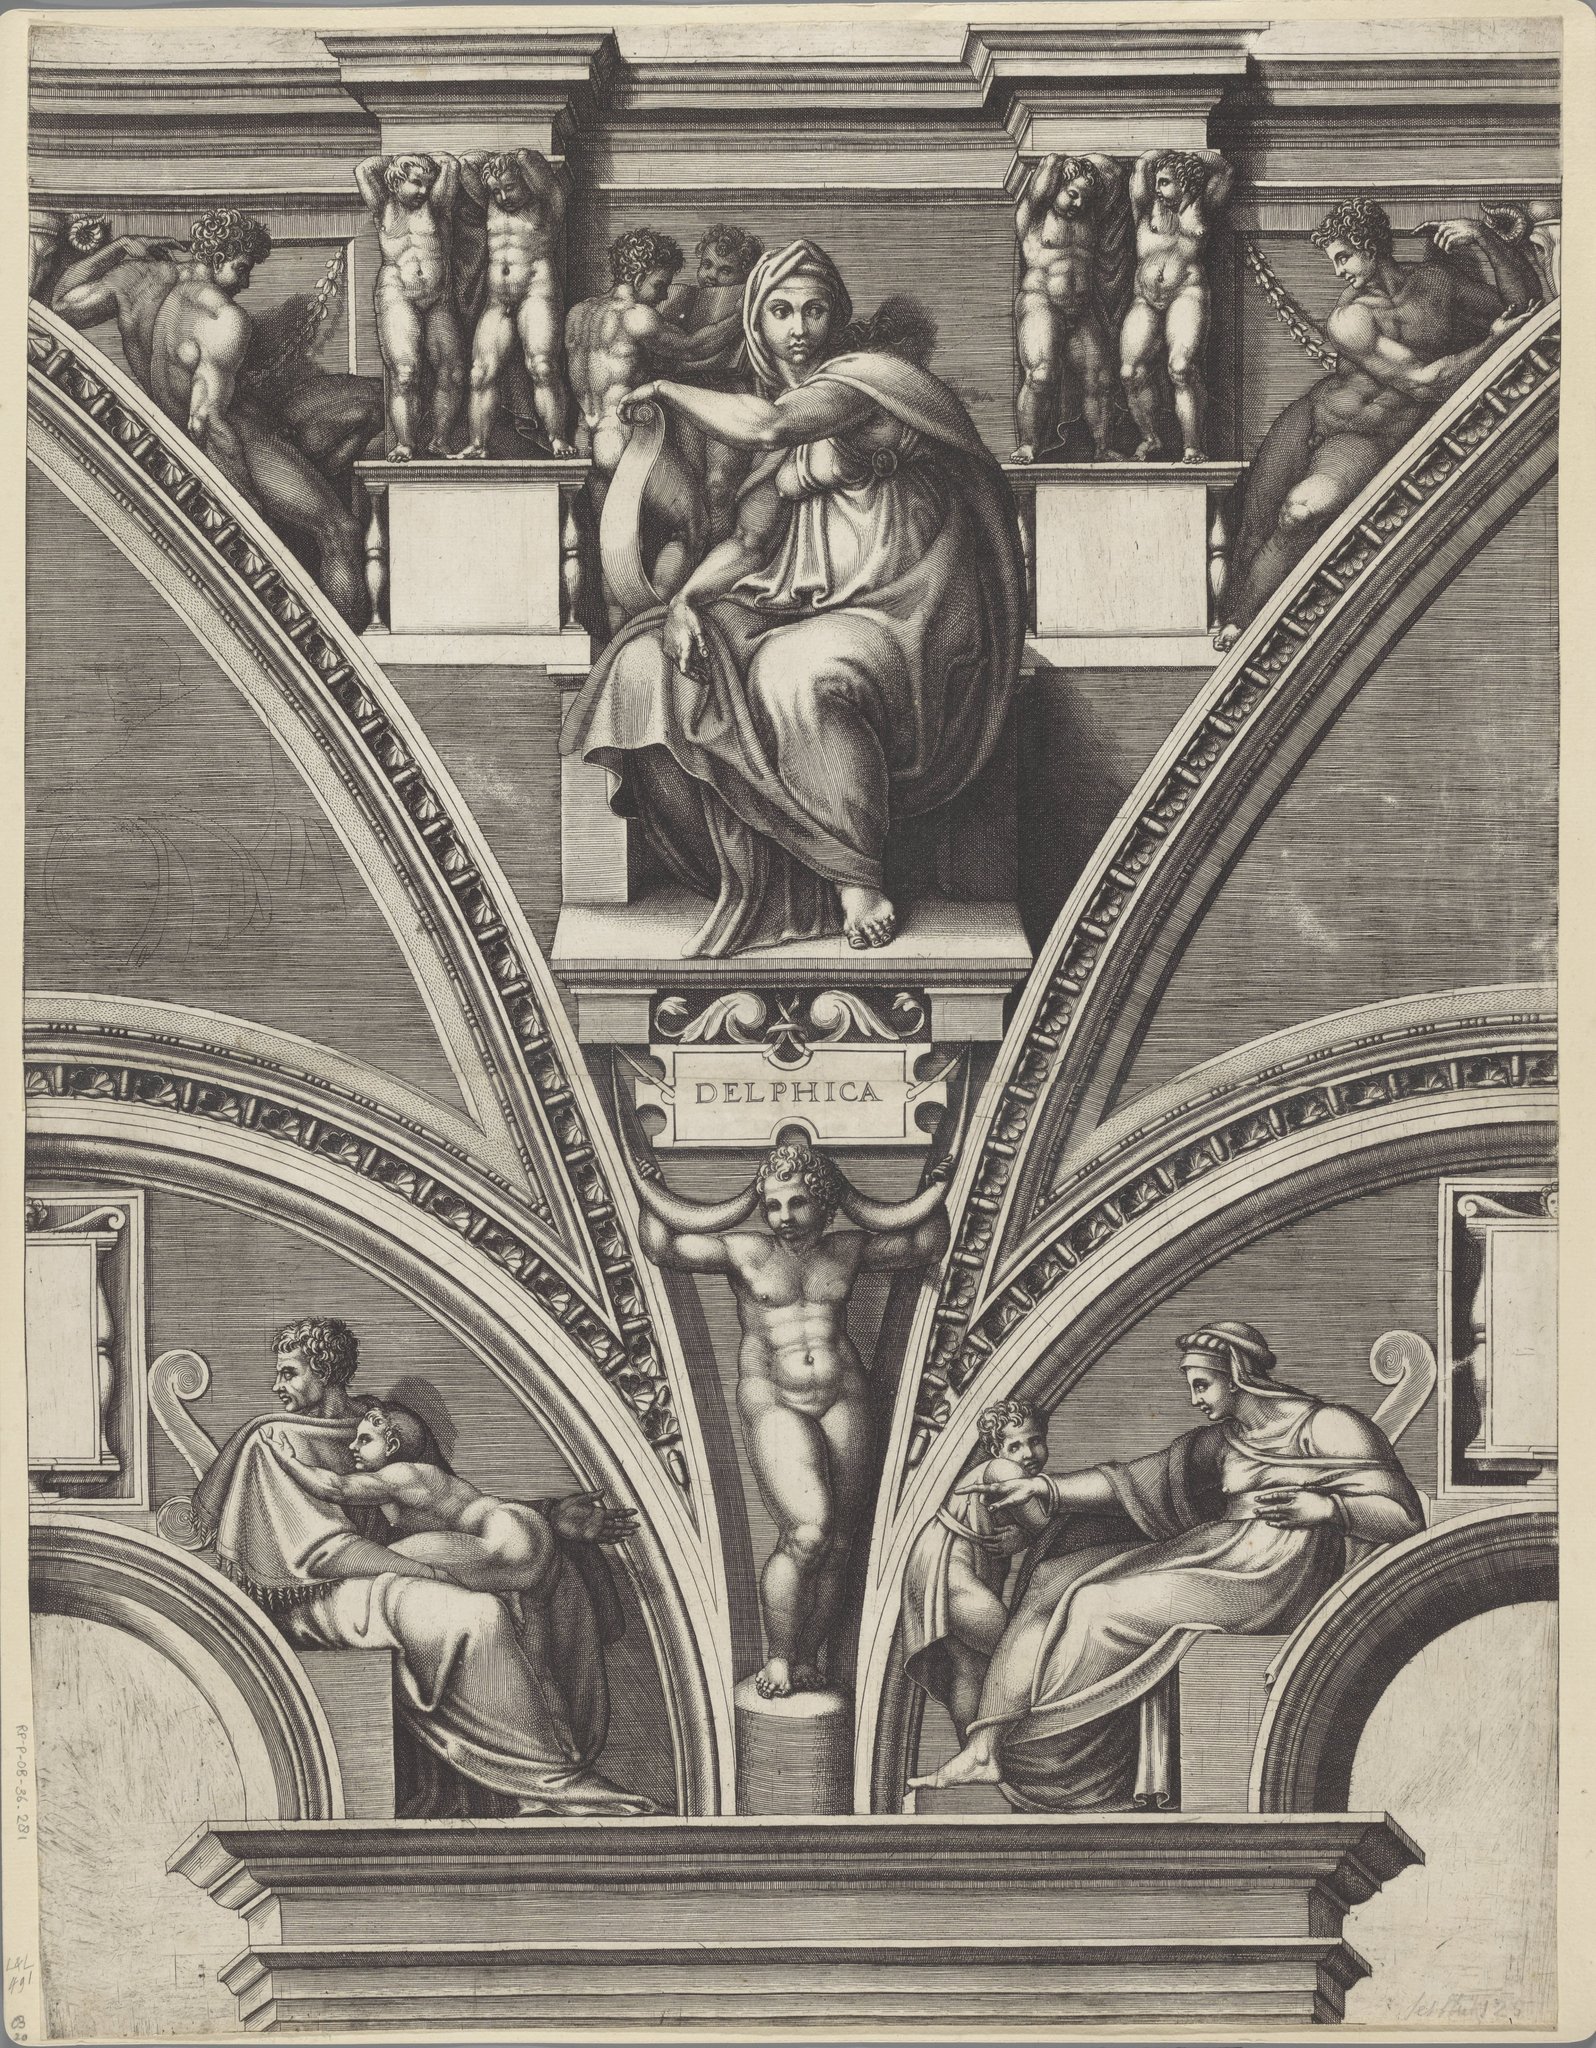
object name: print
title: Delfische Sibille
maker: giorgio ghisi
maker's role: print maker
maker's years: 1520-1582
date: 1530-1582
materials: paper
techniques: engraving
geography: italy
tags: sibyls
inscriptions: collector's mark: Lugt 240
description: Prent uit een reeks van 6 prenten naar de schilderingen in de lunetten boven de ramen in de Sixtijnse Kapel door Michelangelo.